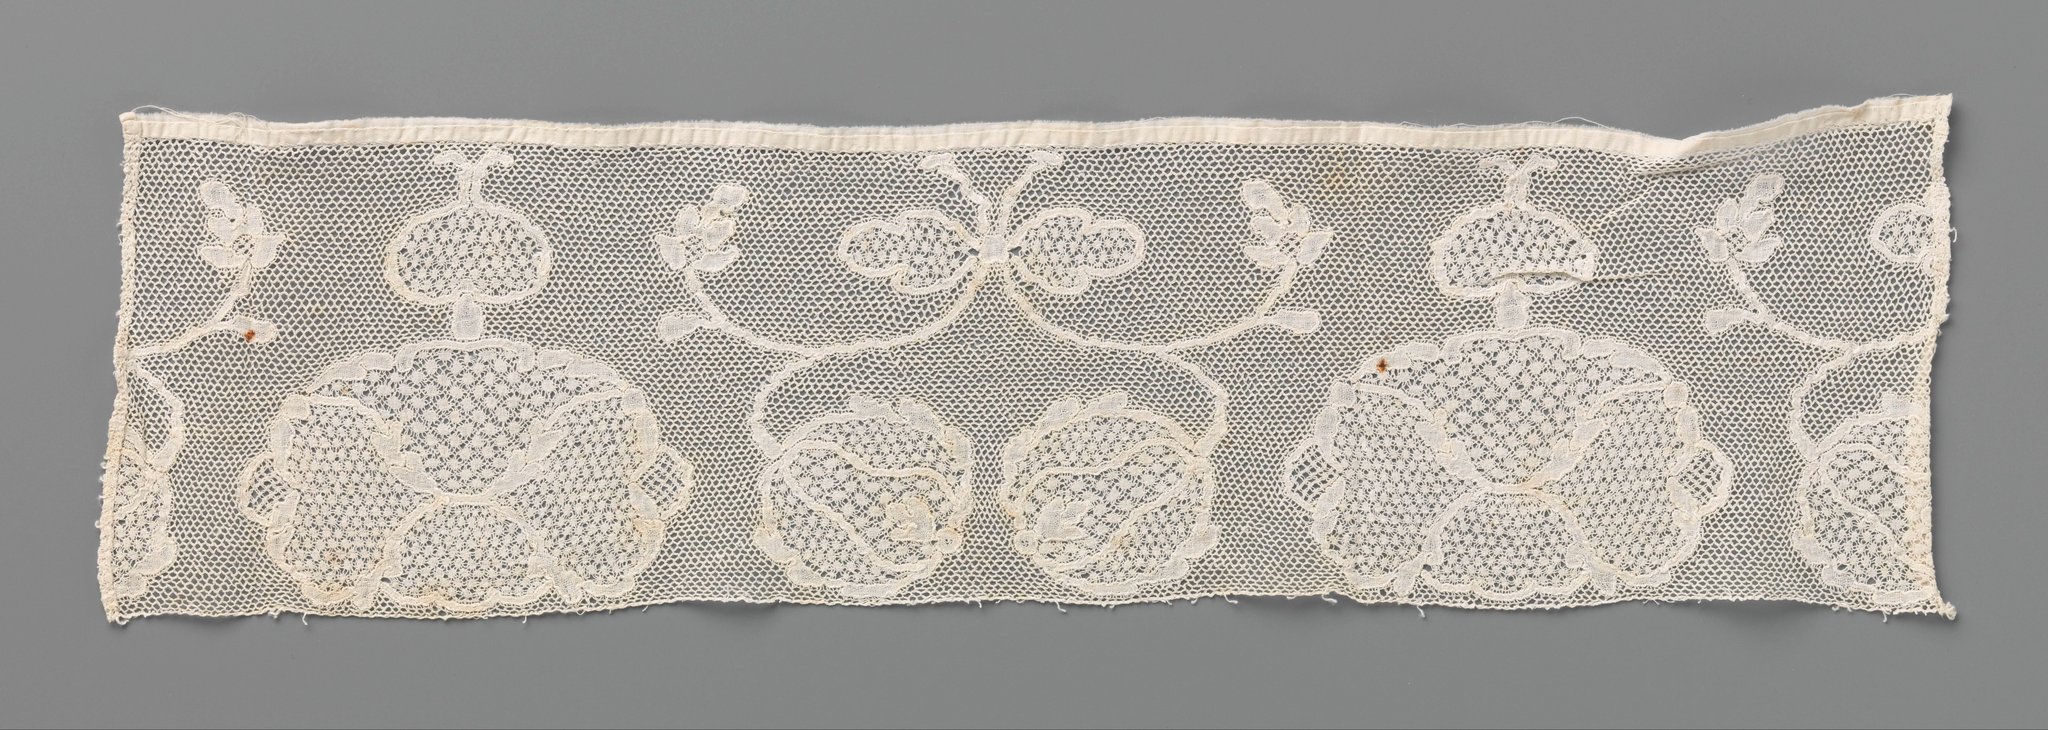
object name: strip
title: Strook kloskant met naar elkaar toegewende ronde bloemen met strik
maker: Anonymous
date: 1750-1799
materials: linen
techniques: lace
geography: southern netherlands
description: Strook naturelkleurige kloskant, pottekant. Het zich herhalende patroon bestaat afwisselend uit twee naar elkaar toegewende ronde bloemen met een s-vormige stelen, die onderaan met een strik zijn samengebonden en een grote ovaalvormige bloem op een steel met een hartvormig motief. De motieven zijn met elkaar verbonden door een maasgrond, de vierkante Valenciennes-grond. De motieven zijn gemaakt in linnenslag met dikkere en glimmende contourdraden. In de bloemen, de strik en het hart zijn verschillende sneeuwvlokkengronden toegepast. De bovenzijde is recht afgewerkt. Langs de onderzijde loopt een smal strookje onafgewerkt linnen. De korte zijden zijn afgewerkt met een zoompje.